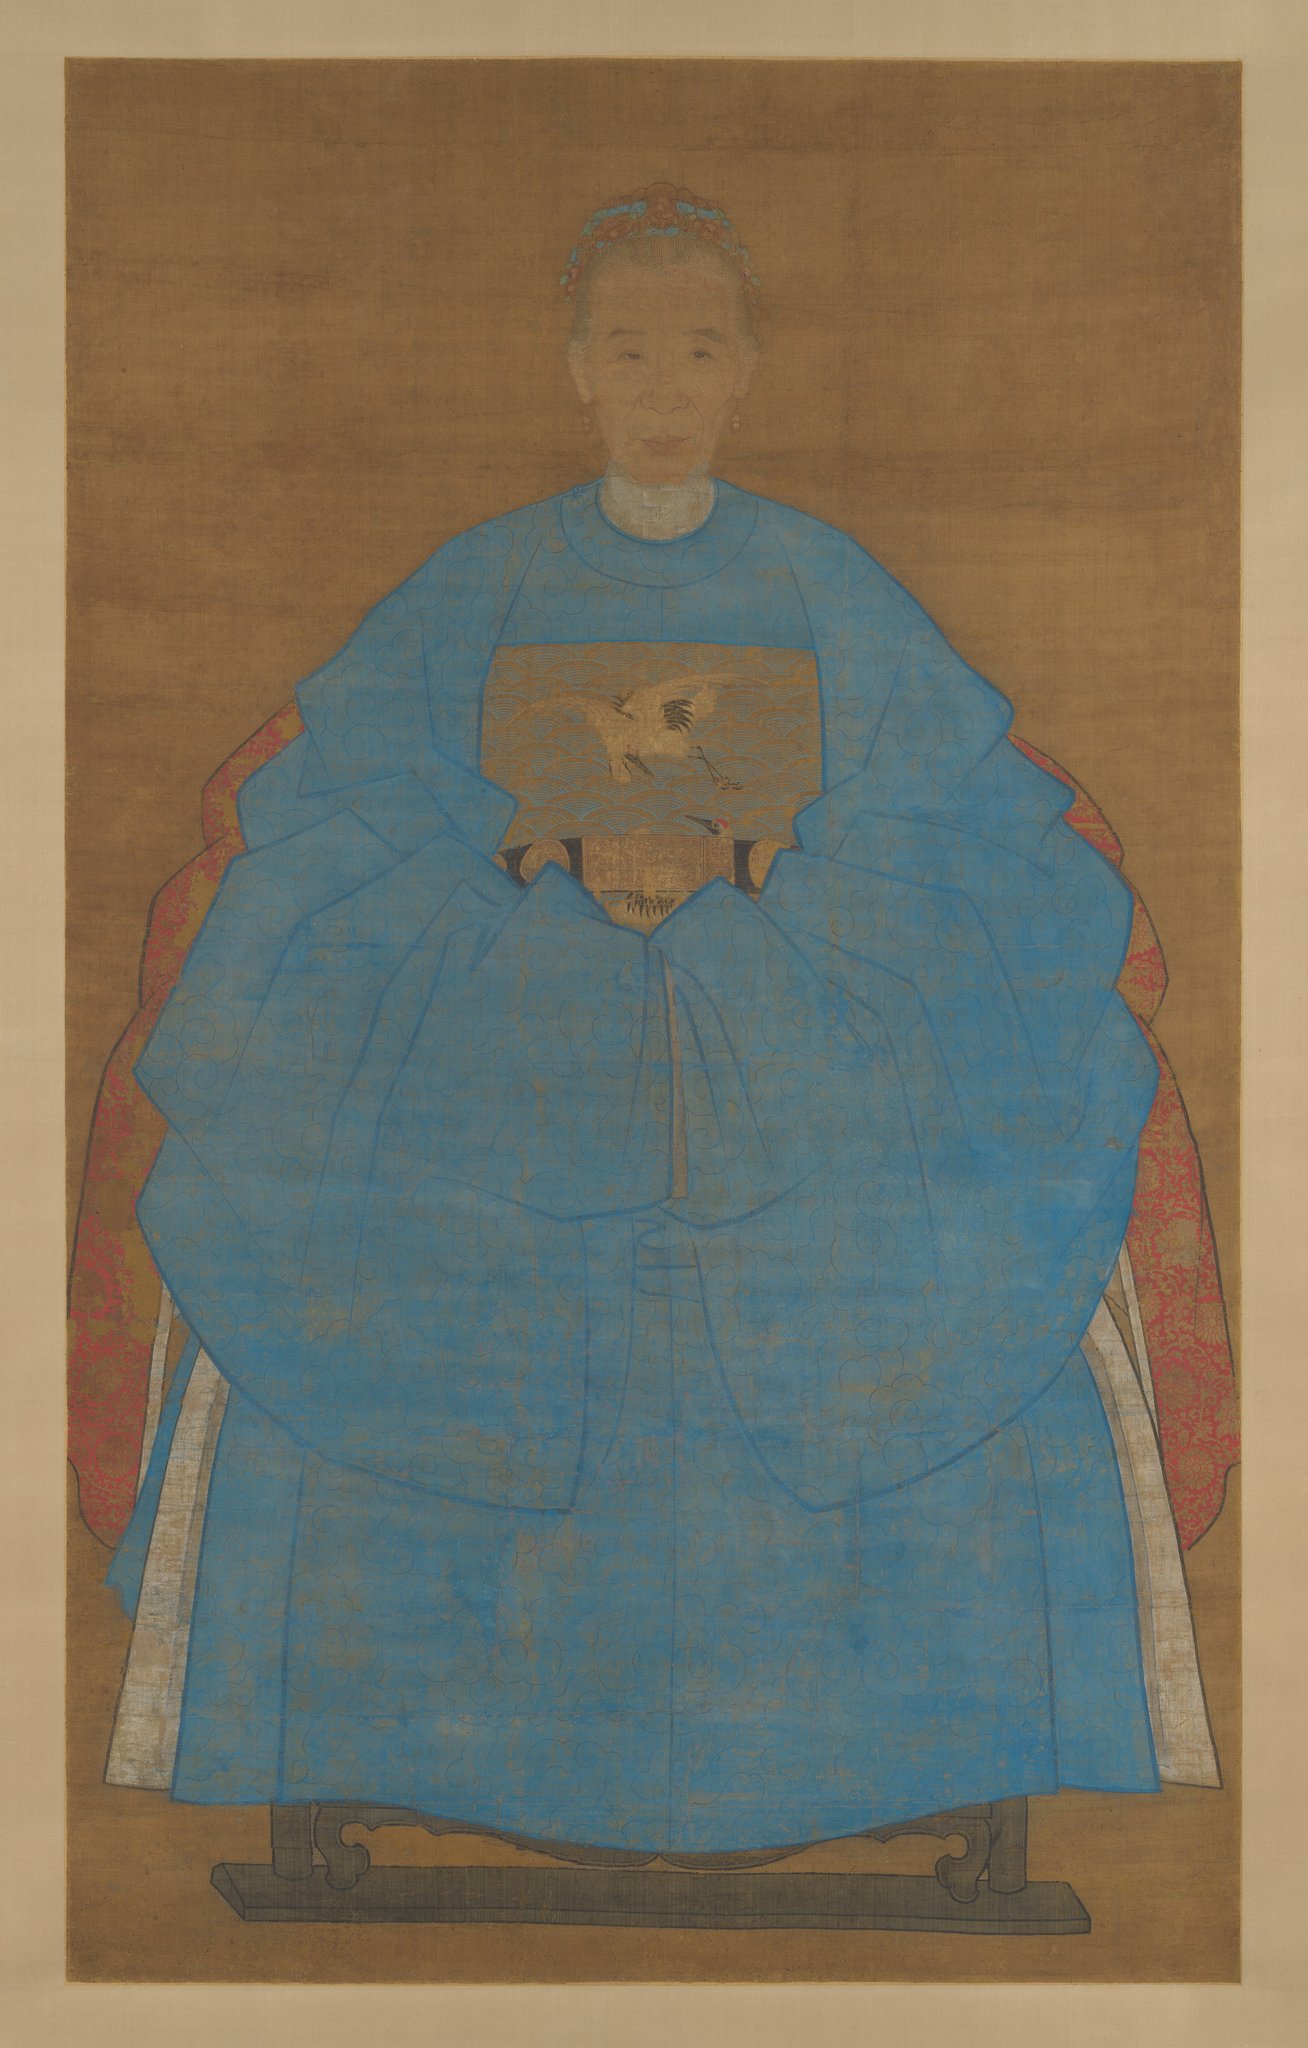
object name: hanging scroll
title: Portrait of the wife of Yizhai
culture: chinese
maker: ruan zude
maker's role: artist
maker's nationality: chinese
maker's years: 1500-1699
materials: ink, silk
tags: portraits,women